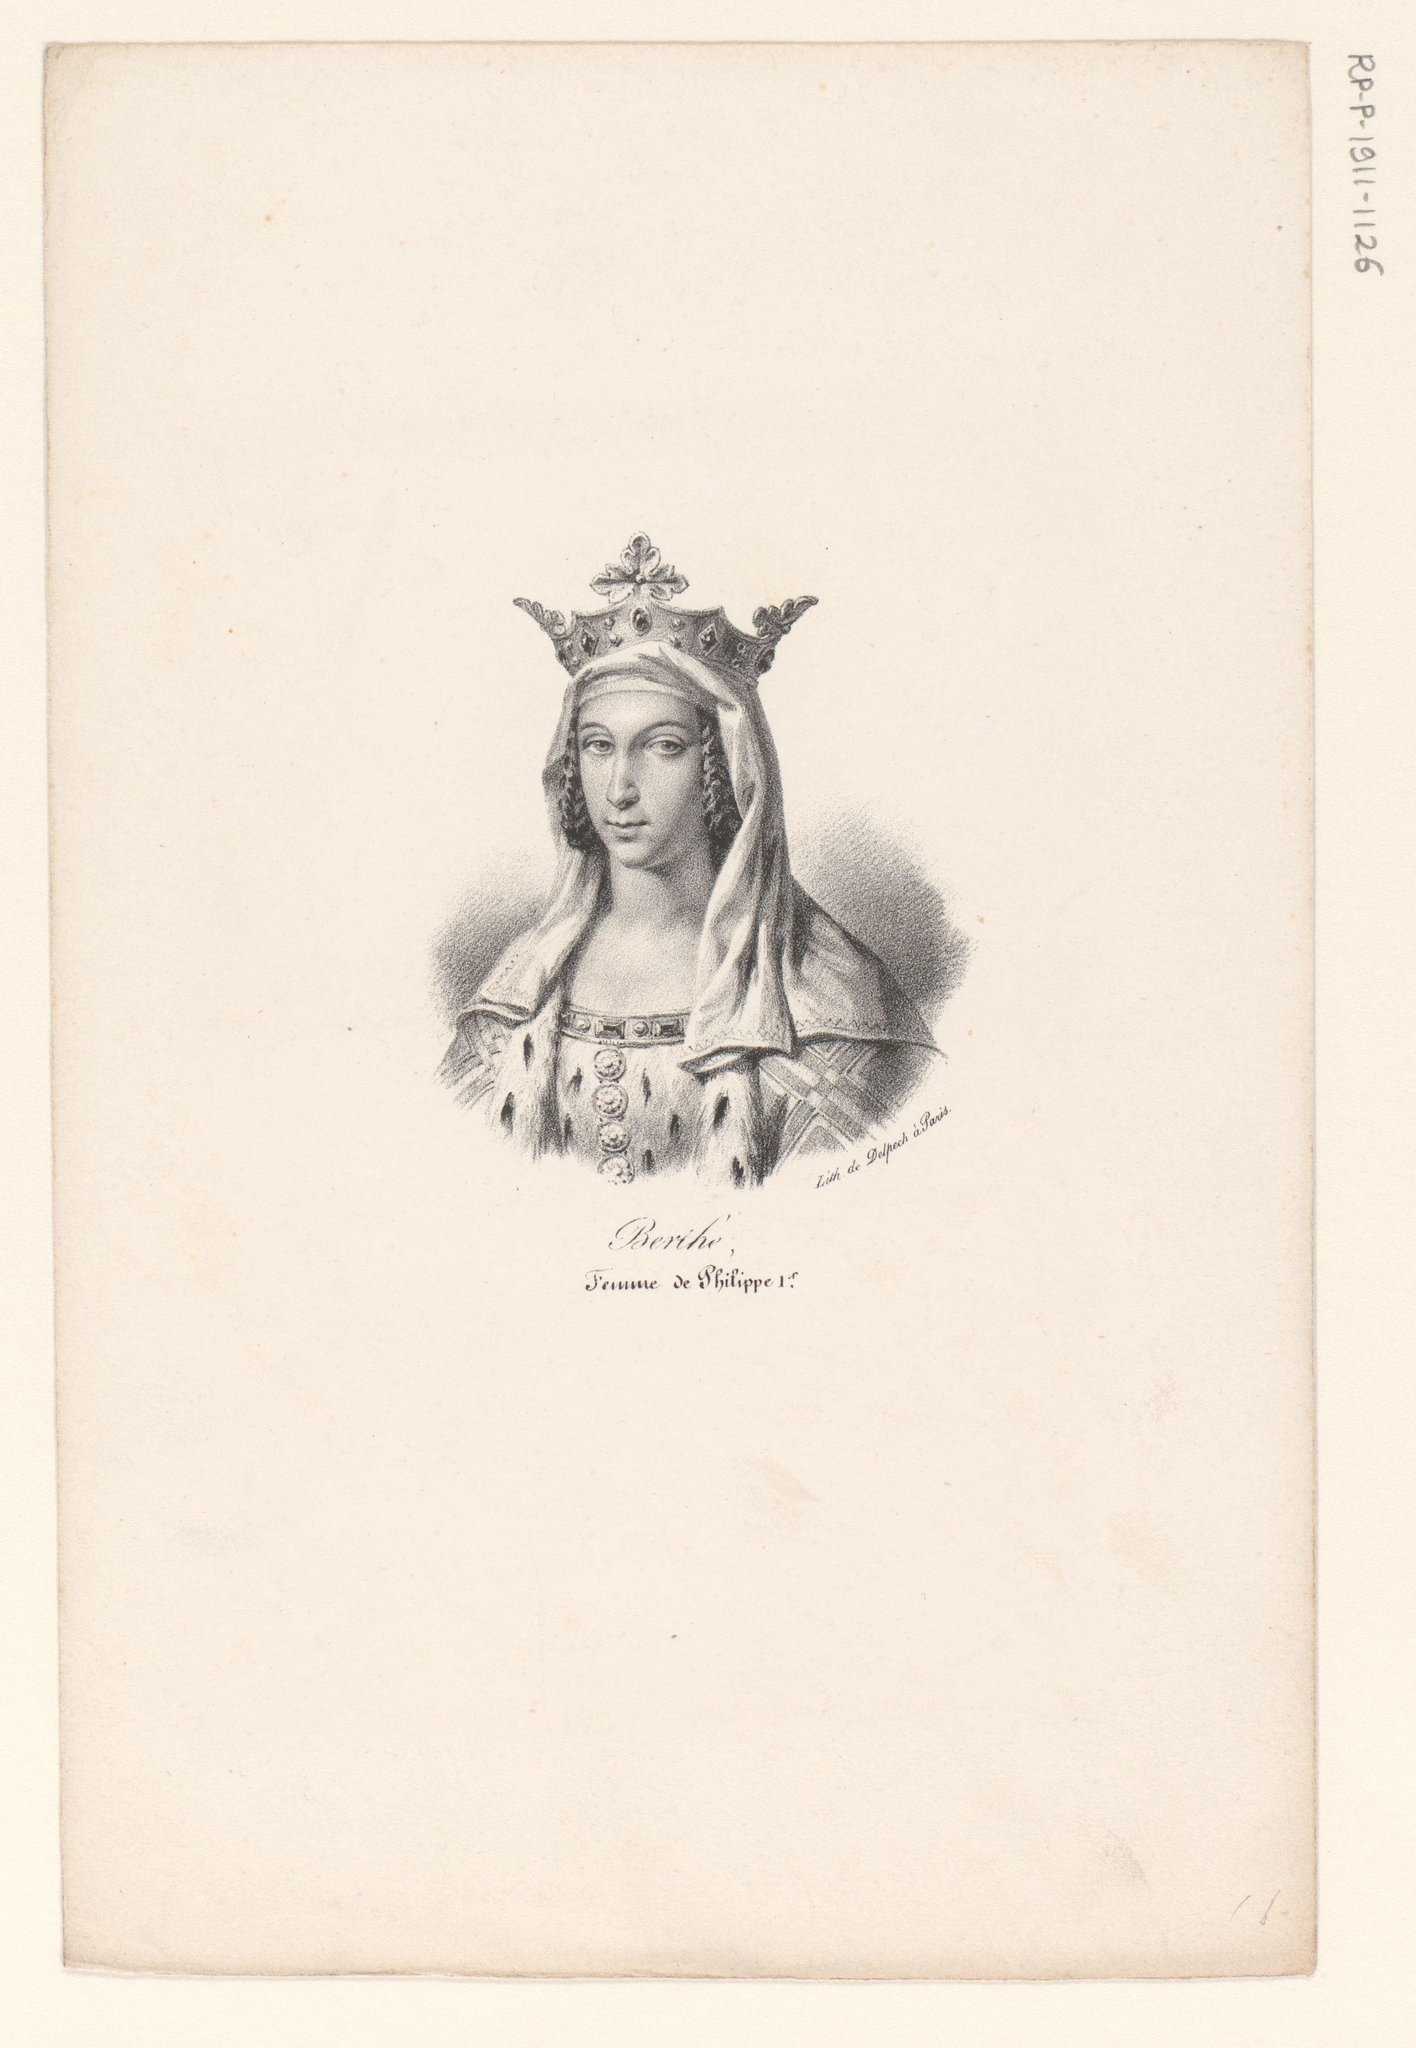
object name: print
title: Portret van Bertha van Holland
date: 1818-1842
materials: paper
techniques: lithograph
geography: paris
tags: holland, historical persons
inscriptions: collector's mark: Lugt 2228a